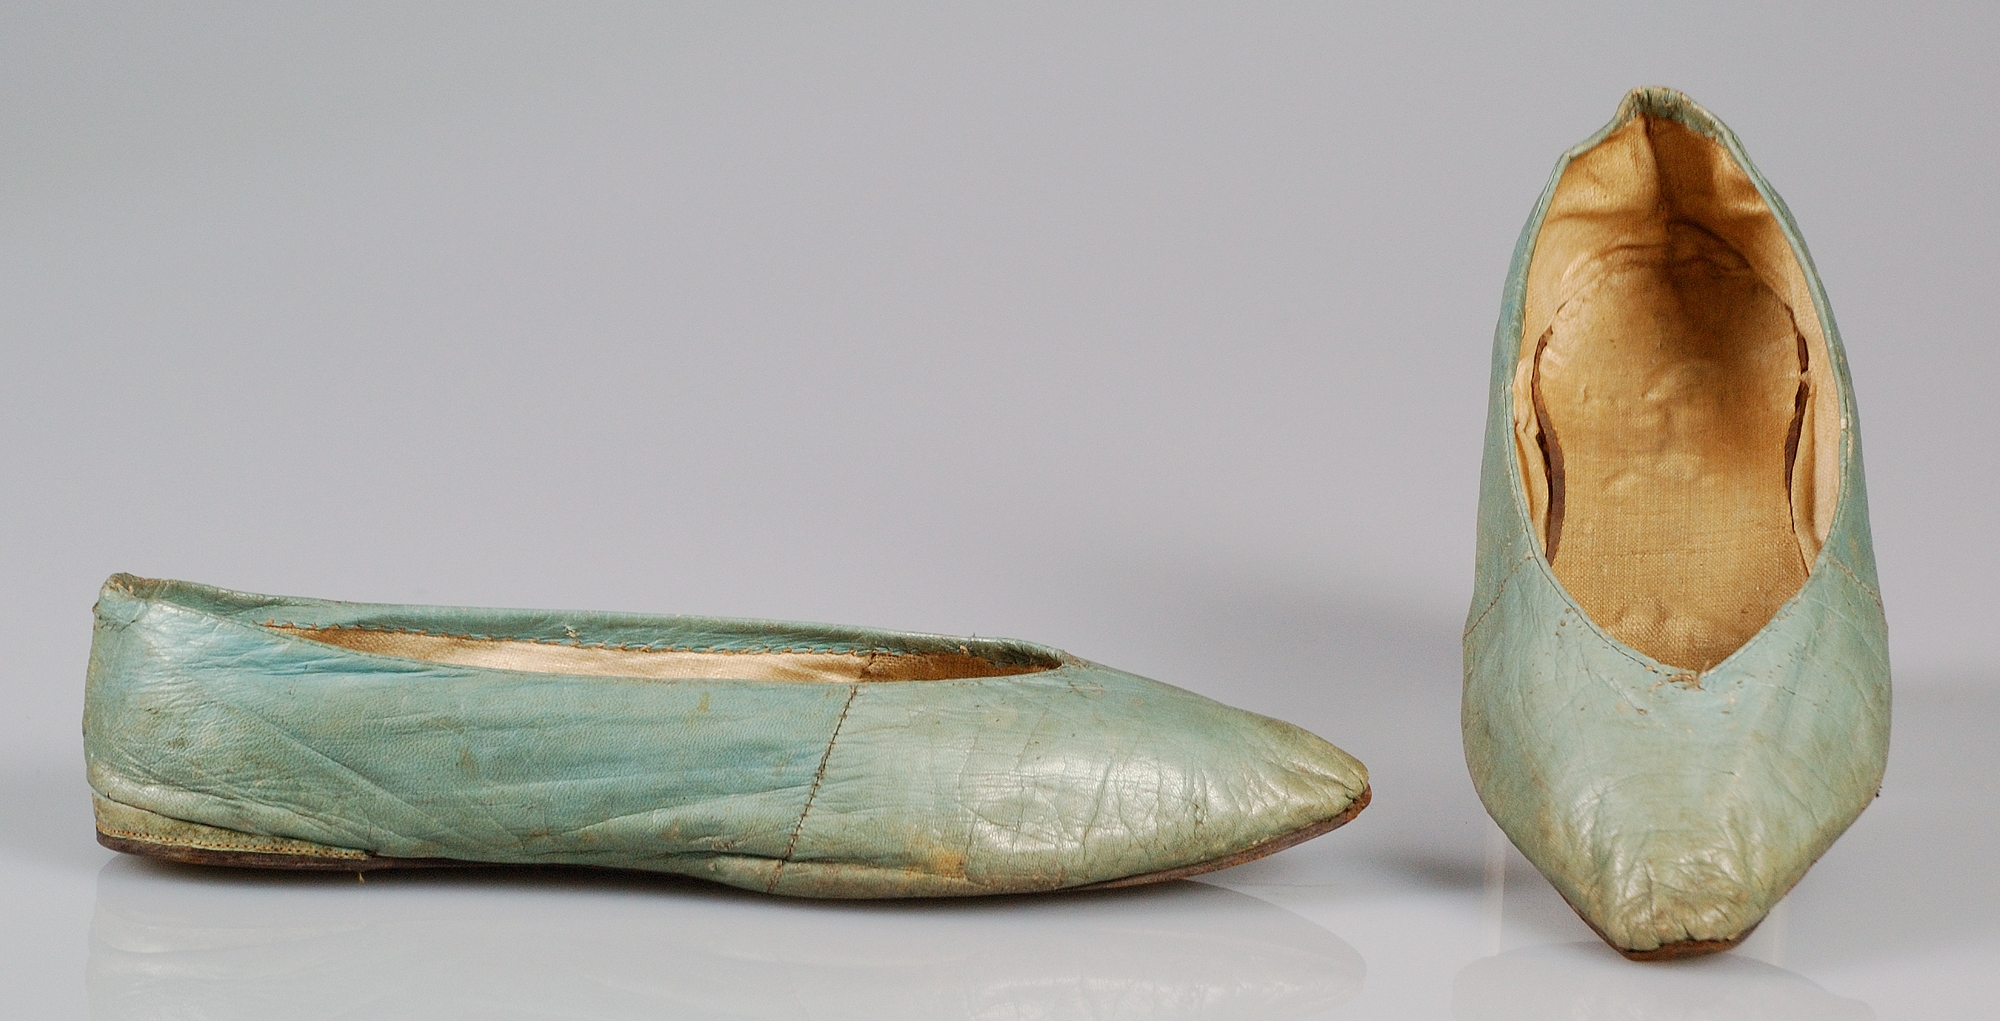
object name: slipper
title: Slippers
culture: british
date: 1800-1815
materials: leather